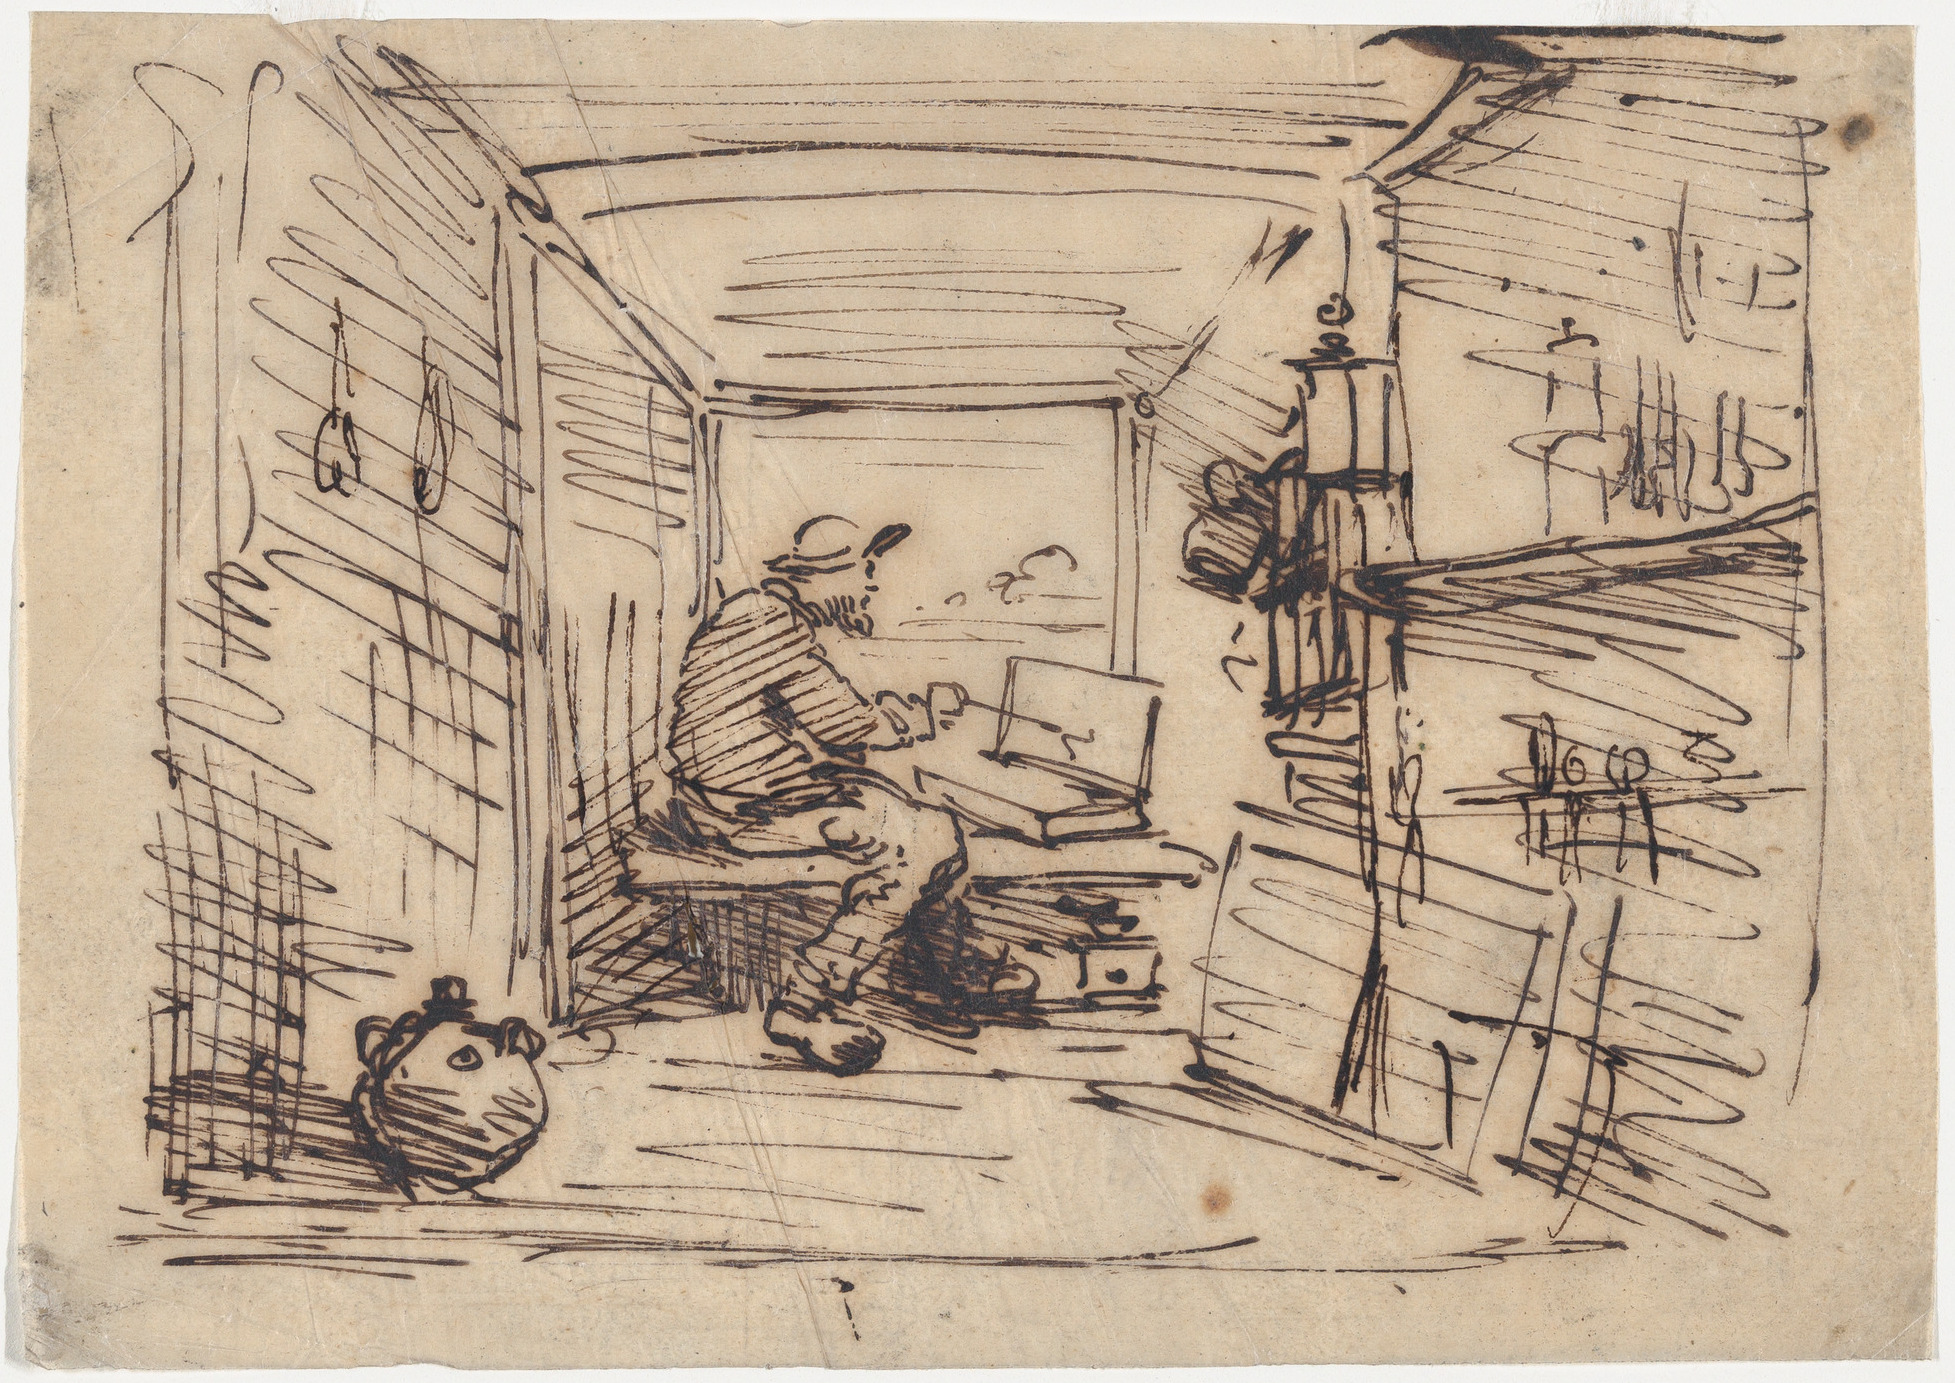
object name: drawing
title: The Boat Studio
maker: charles-françois daubigny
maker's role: artist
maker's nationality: french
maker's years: 1817-1878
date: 1862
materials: ink, paper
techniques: pen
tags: painting,men